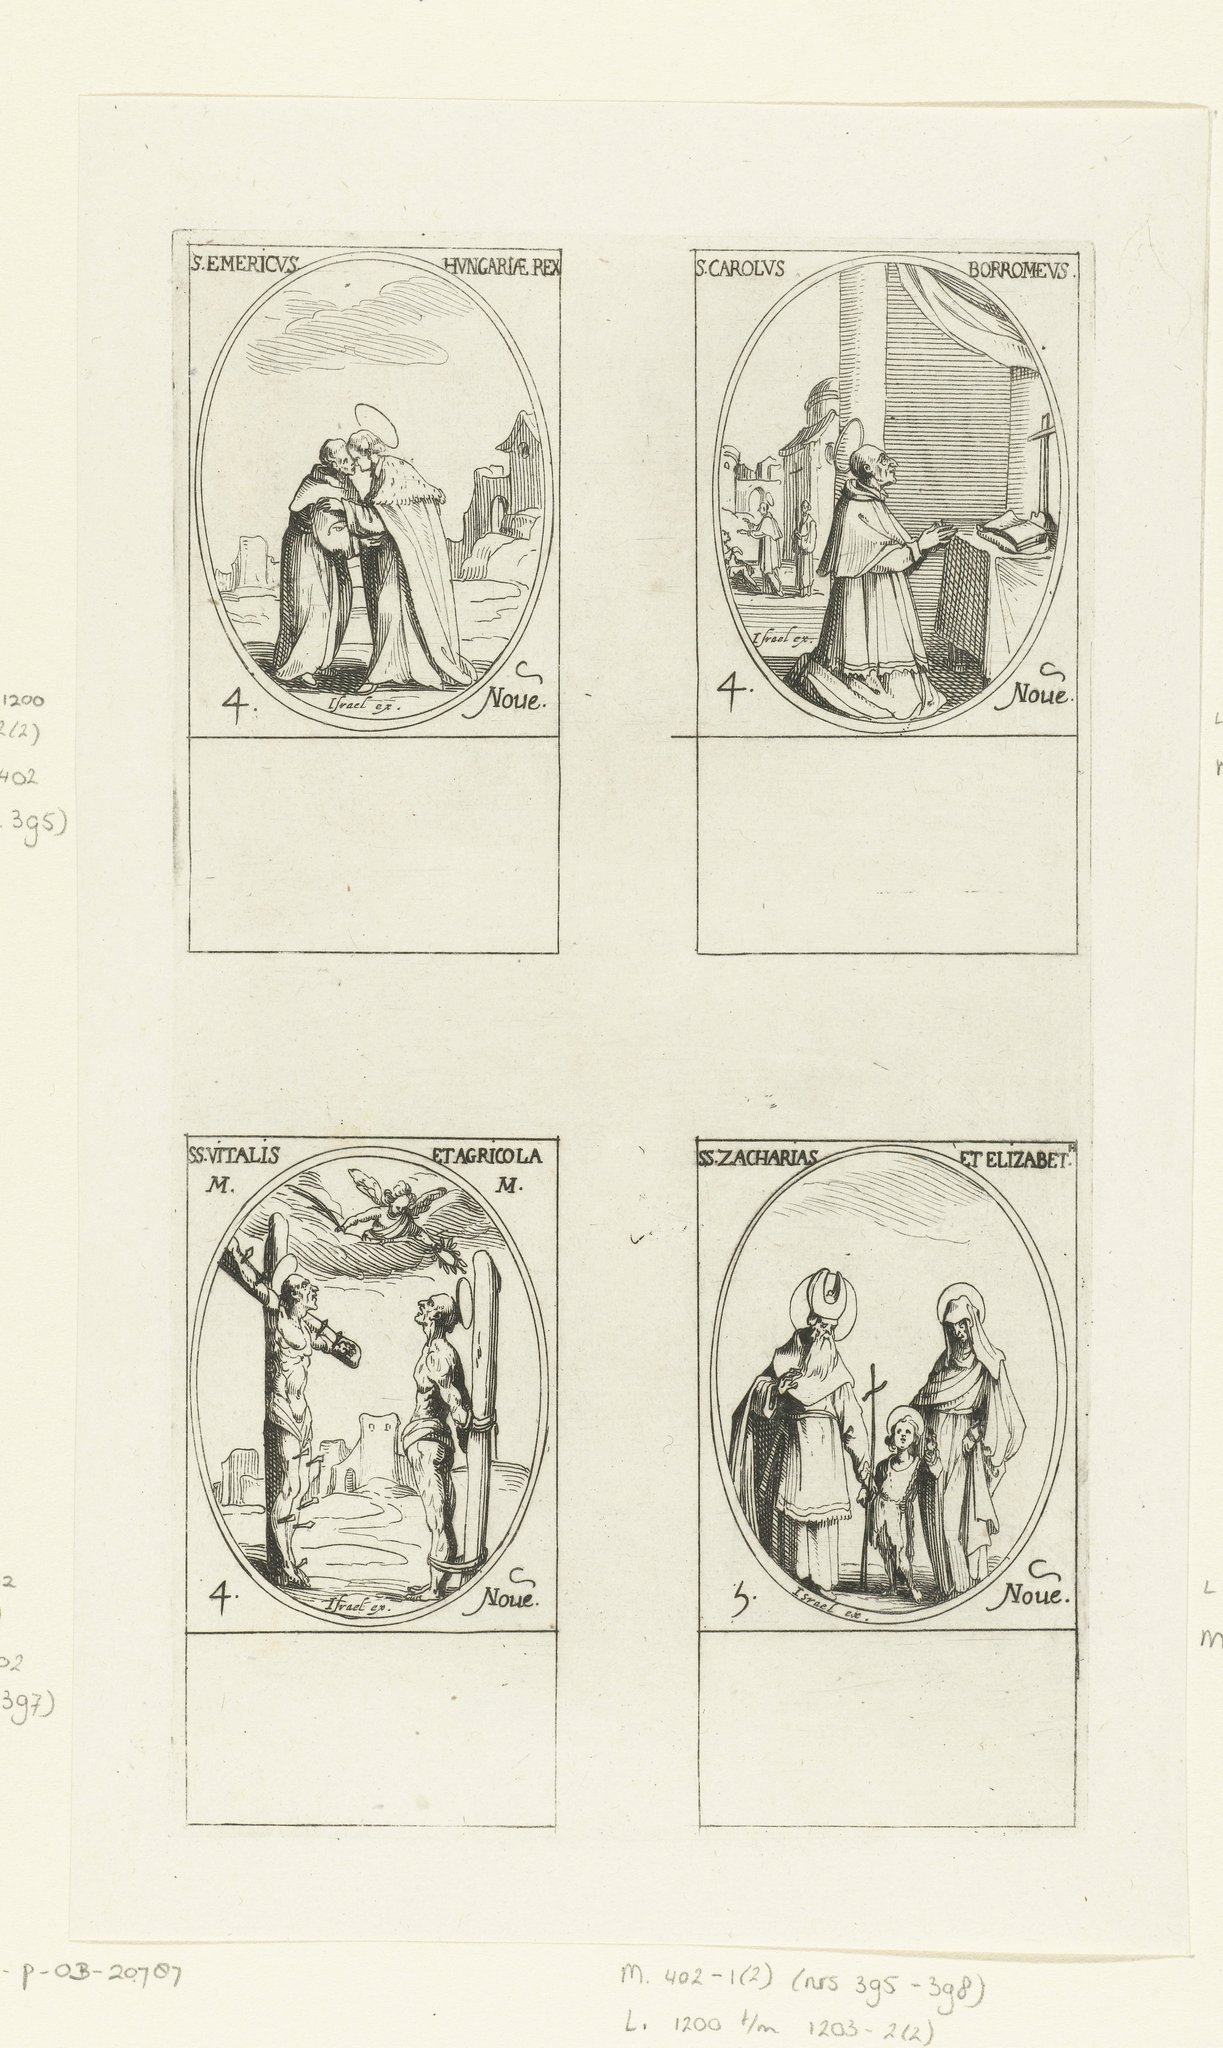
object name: print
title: Heilige Emeric van Hongarije, Heilige Carolus Borromaeus, Heilige Vitalis en Heilige Agricola van Bologna, Heilige Zacharias en Heilige Elizabeth met de Heilige Johannes de Doper (4-5 november)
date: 1632-1636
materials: paper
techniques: etching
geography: paris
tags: elisabeth, mother of john the baptist; possible attributes: john the baptist as child, male saints (with name)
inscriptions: collector's mark: Lugt 240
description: Blad met vier ovale voorstellingen, elk met opschrift en datum in het Latijn: linksboven de Heilige Emeric van Hongarije die een geestelijke groet, rechtsboven de Heilige Carolus Borromaeus geknield voor een altaar, linksonder de Heilige Vitalis en de Heilige Agricola respectievelijk gekruisigd en aan een paal gebonden, rechtsonder Zacharias, Elizabeth en hun zoon Johannes de Doper. Deze prent is onderdeel van een serie prenten met voorstellingen van de heiligen en de christelijke feestdagen van het jaar. Er zijn steeds vier scènes van één plaat op één blad gedrukt. Inclusief bijbehorend titelblad en frontispice gaat het in totaal om 124 platen (490 voorstellingen). De drie platen met de laatste 12 scènes (de veranderlijke christelijke feestdagen) zijn in de derde staat versneden tot 12 kleine plaatjes, en met een apart titelblad uitgegeven.